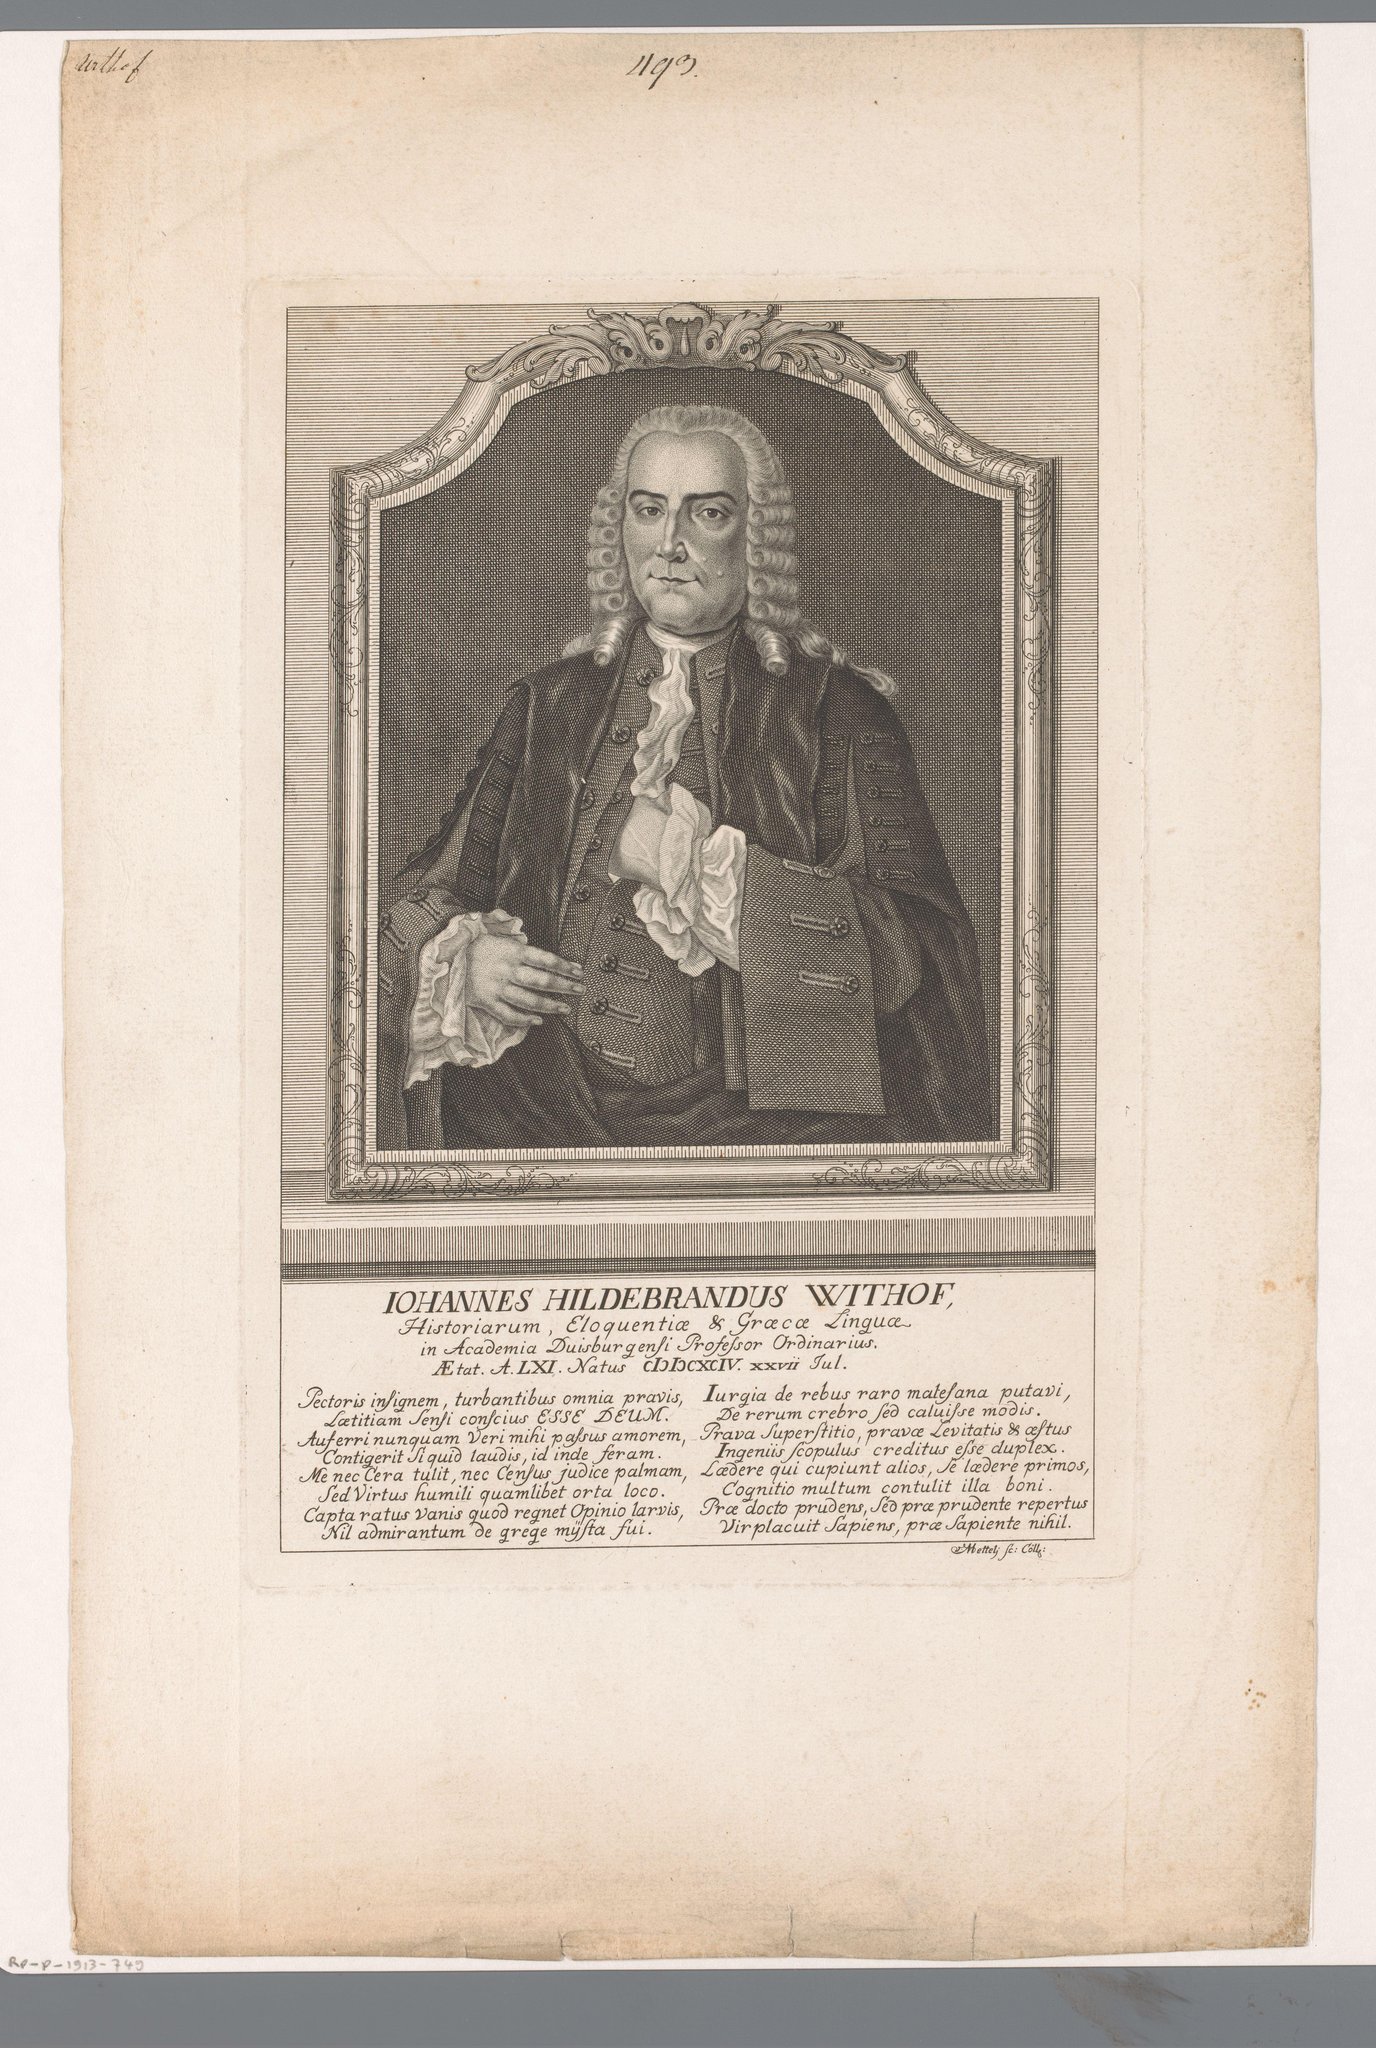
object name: print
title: Portret van Johann Hildebrand Withof op 61-jarige leeftijd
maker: nicolaus mettel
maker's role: print maker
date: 1755-1778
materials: paper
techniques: engraving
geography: cologne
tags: johann hildebrand withof, historical persons, wig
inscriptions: collector's mark: Lugt 2228